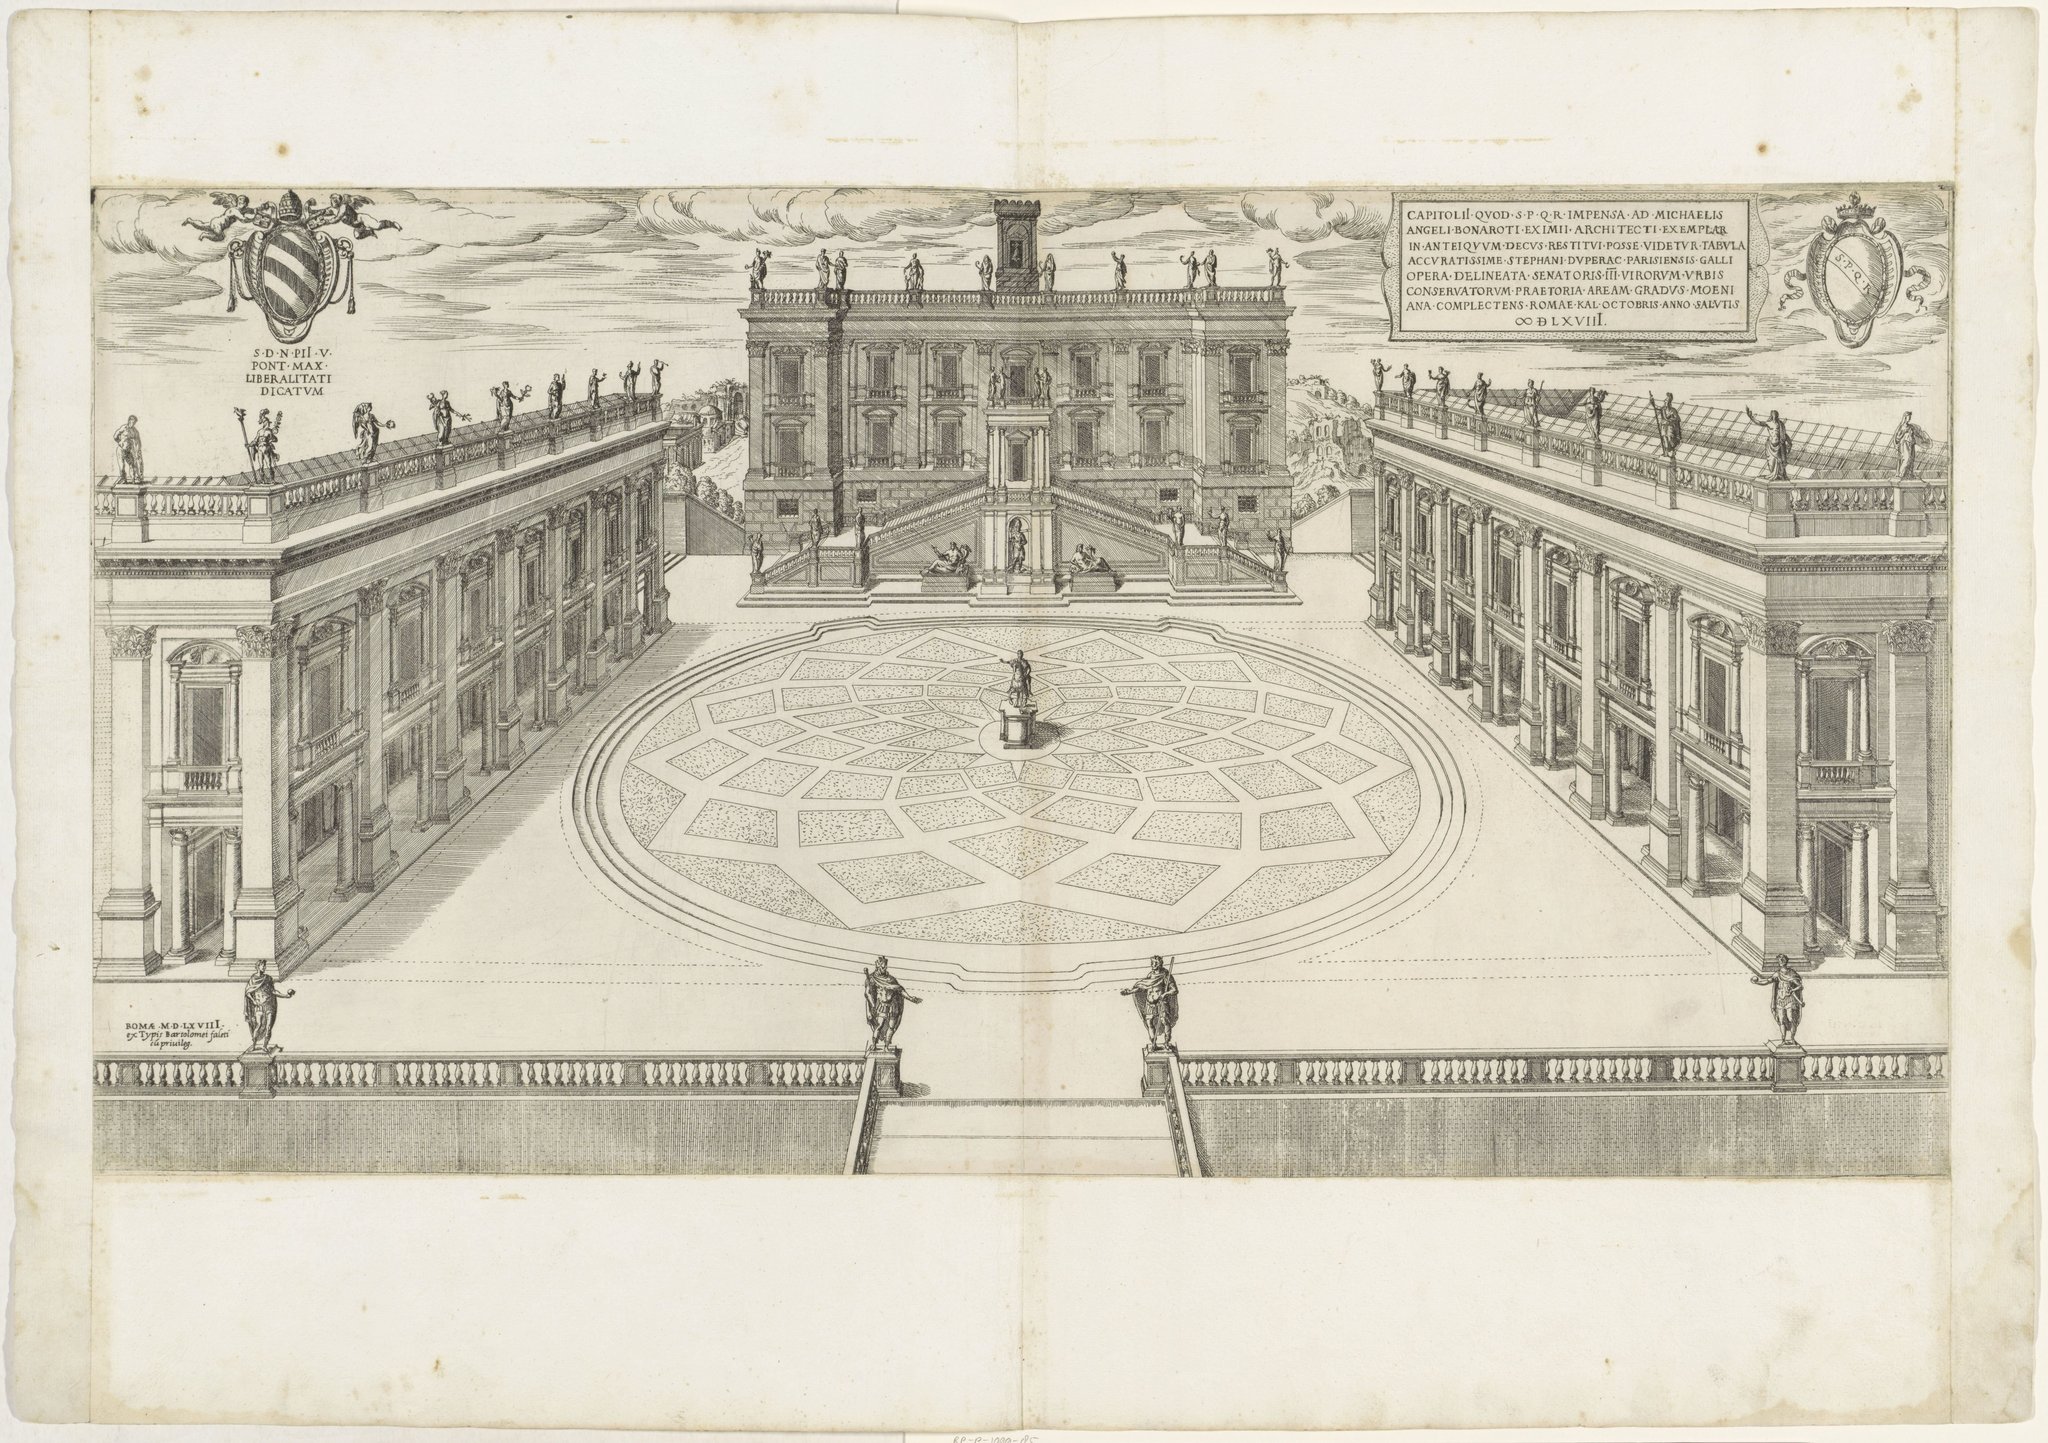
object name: print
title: Piazza del Campidoglio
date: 1568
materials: paper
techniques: engraving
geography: rome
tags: square, place, circus, etc., equestrian statue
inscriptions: watermark, number: ‘96’, collector's mark: Lugt 2760, collector's mark: Lugt 2228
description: The section on architecture in the Zobel Album contains prints of ancient and modern Italian structures, as well as imaginary ones. This large print affords a bird’s-eye view of the Piazza del Campidoglio in Rome designed by Michelangelo. Four mounting strips of white paper were affixed around the print so that, when it was folded in half, it fit perfectly into the album.